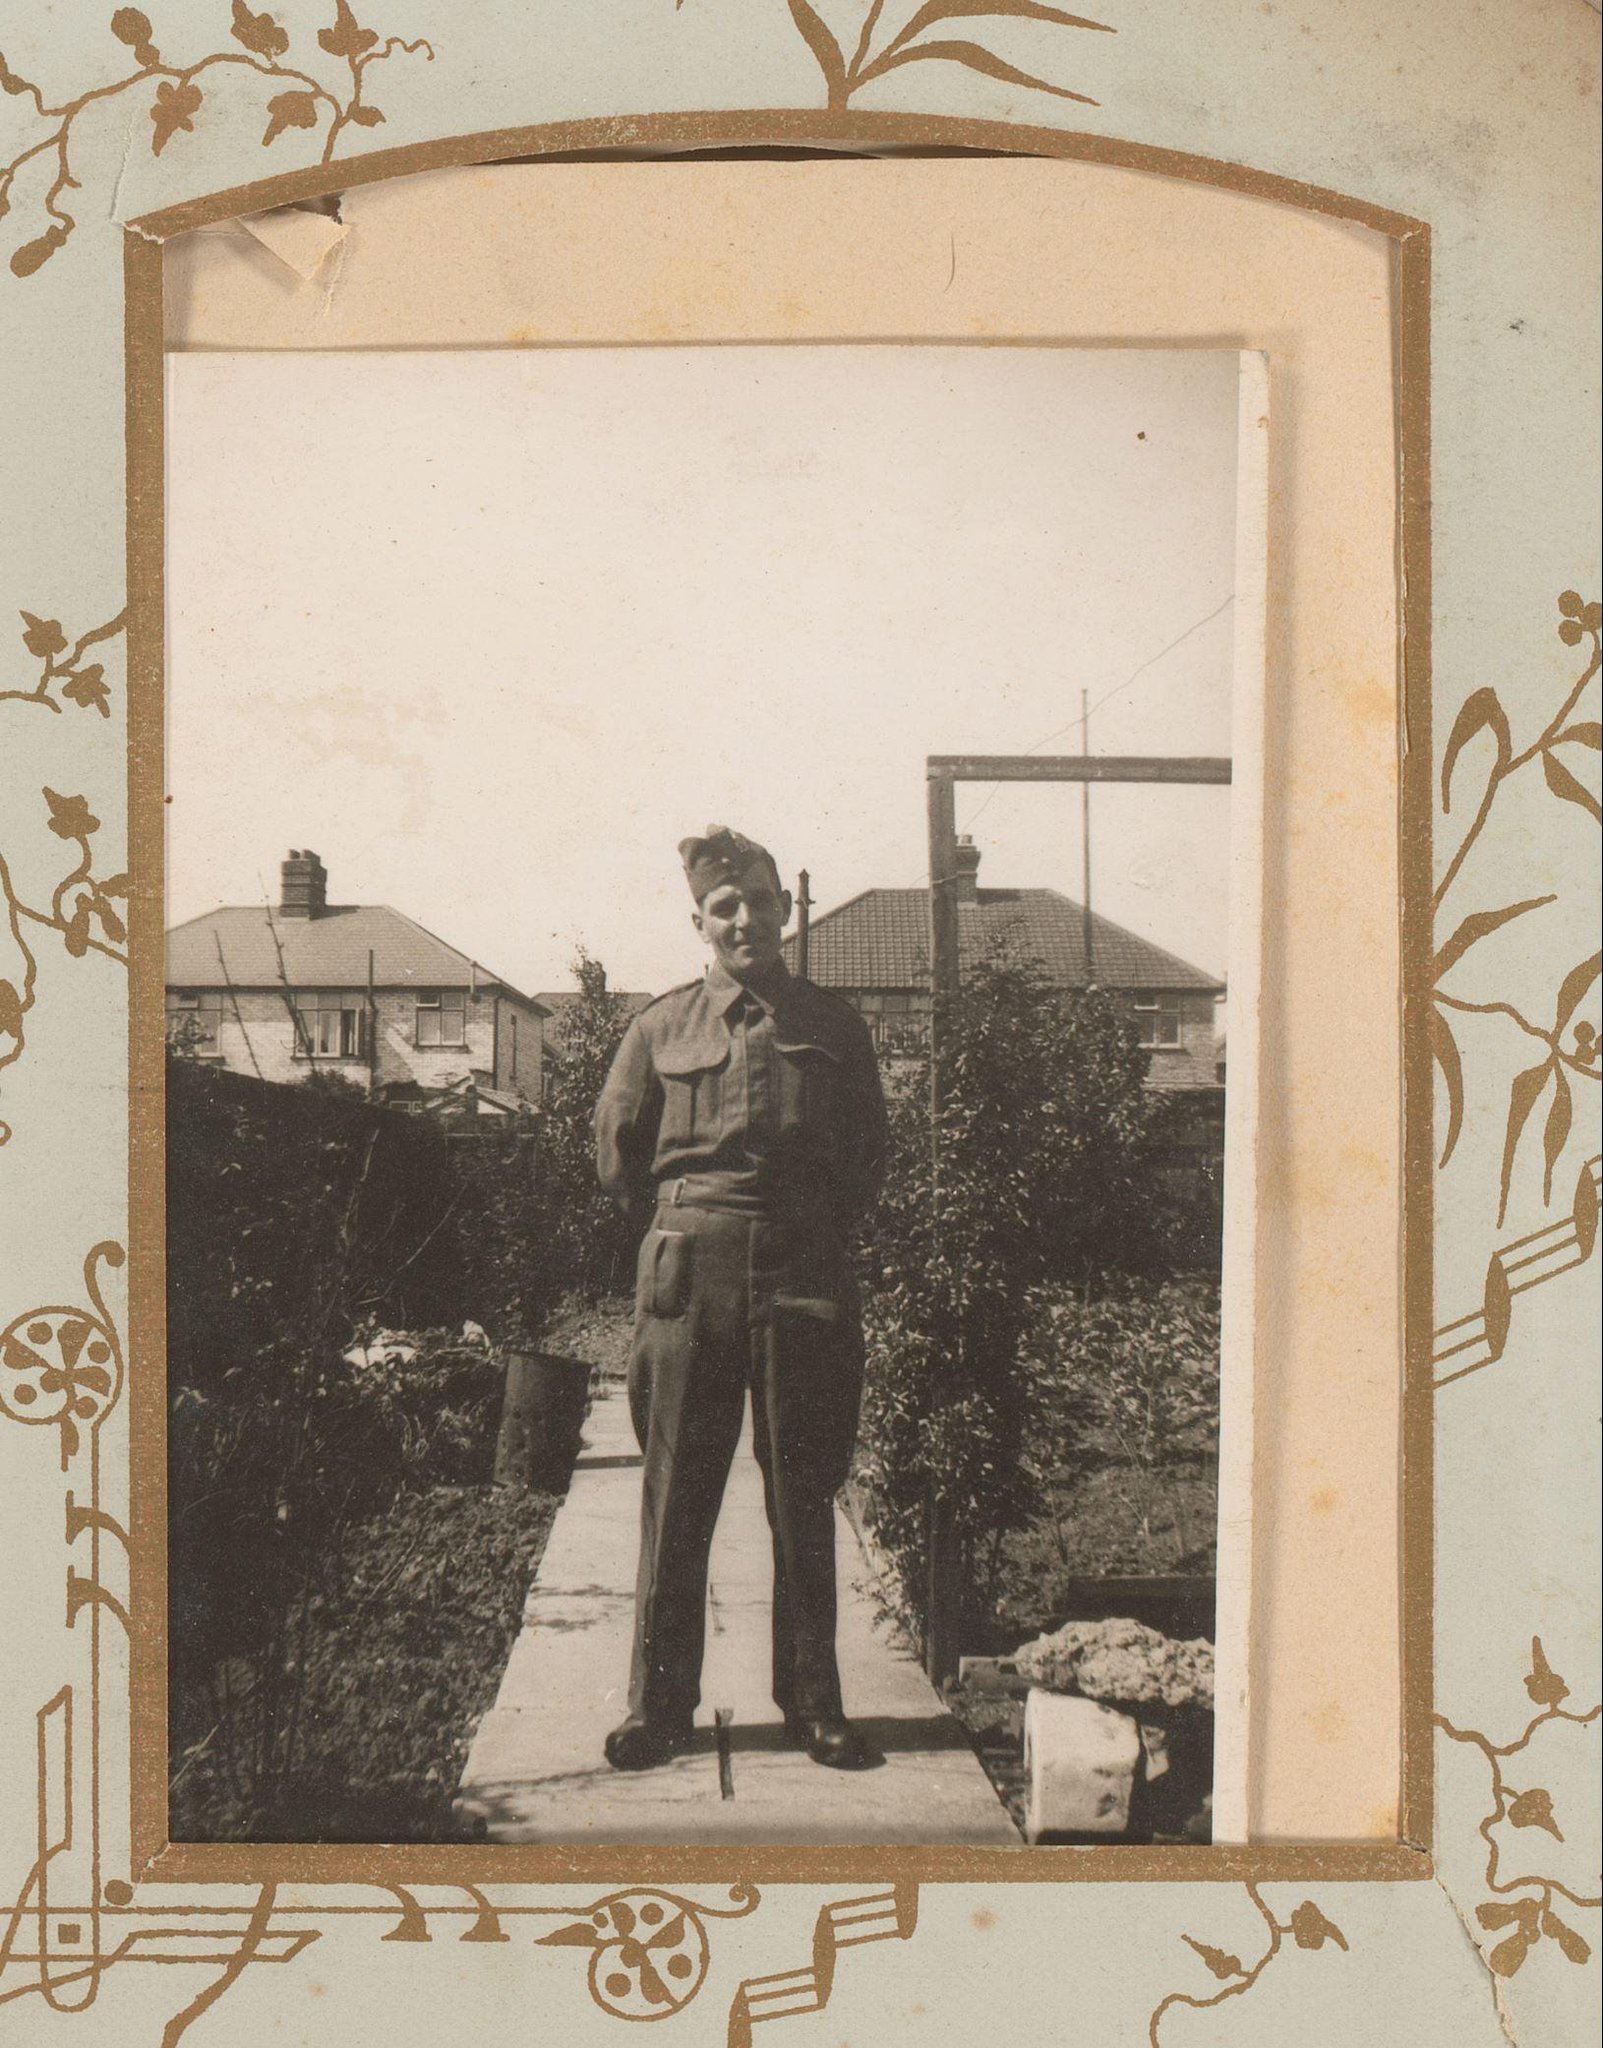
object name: album leaf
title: Portret van een militair in uniform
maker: Anonymous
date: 1899-1940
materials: photographic support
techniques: collodion silver print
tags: adult man, historical persons, (military) uniforms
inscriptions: inscription: ‘POst Card/ Carte postale/ Kodak’